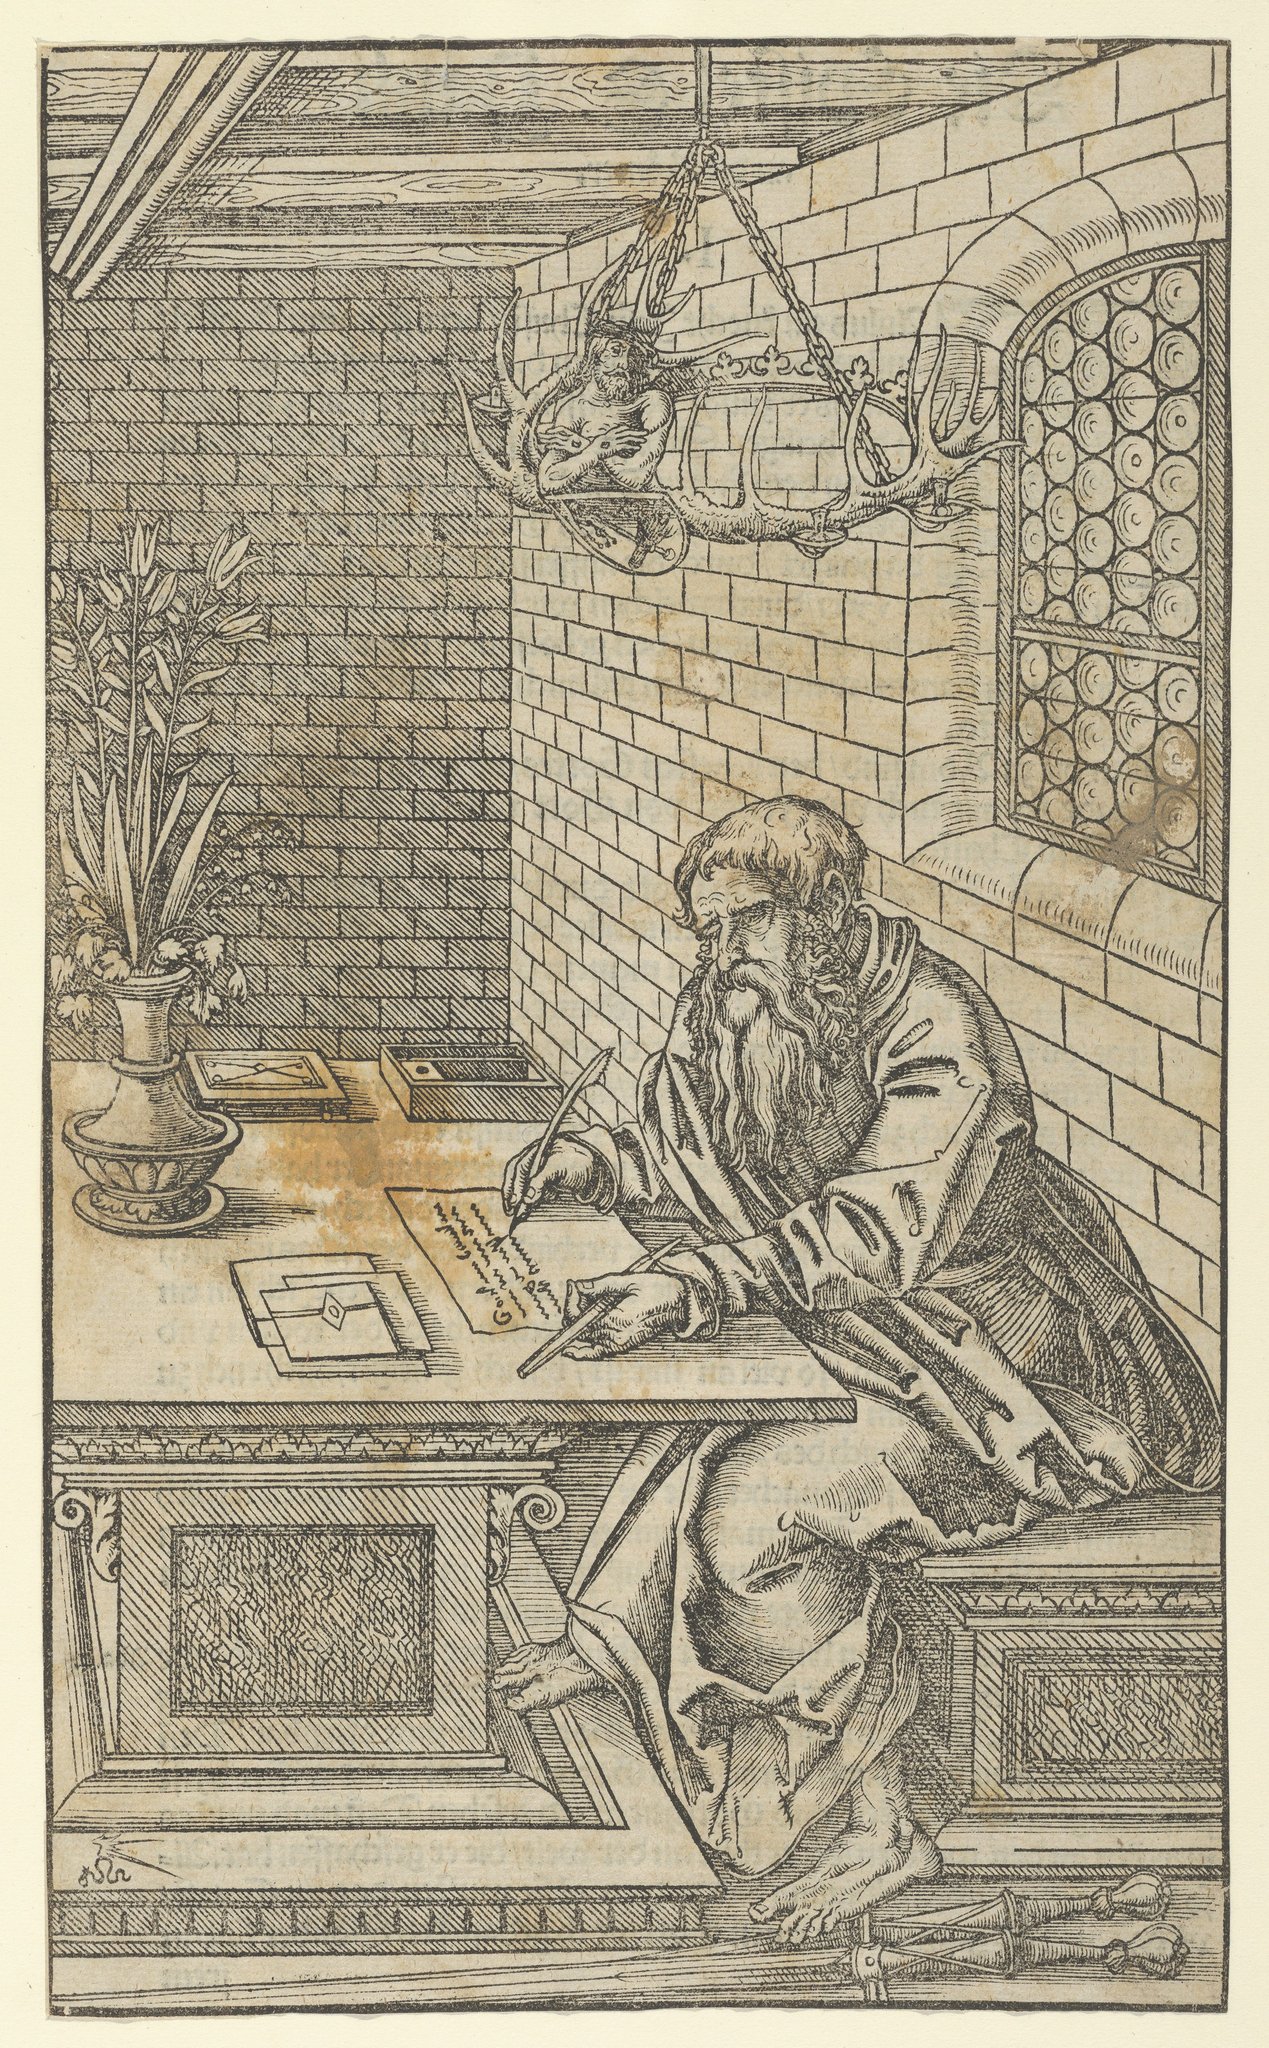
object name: print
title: Paul, from "The Four Evangelists and Three Apostles Sitting in Rooms"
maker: lucas cranach the younger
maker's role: artist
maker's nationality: german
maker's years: 1515-1586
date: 1515-1586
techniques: woodcut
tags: apostles,saint paul,writing,desks